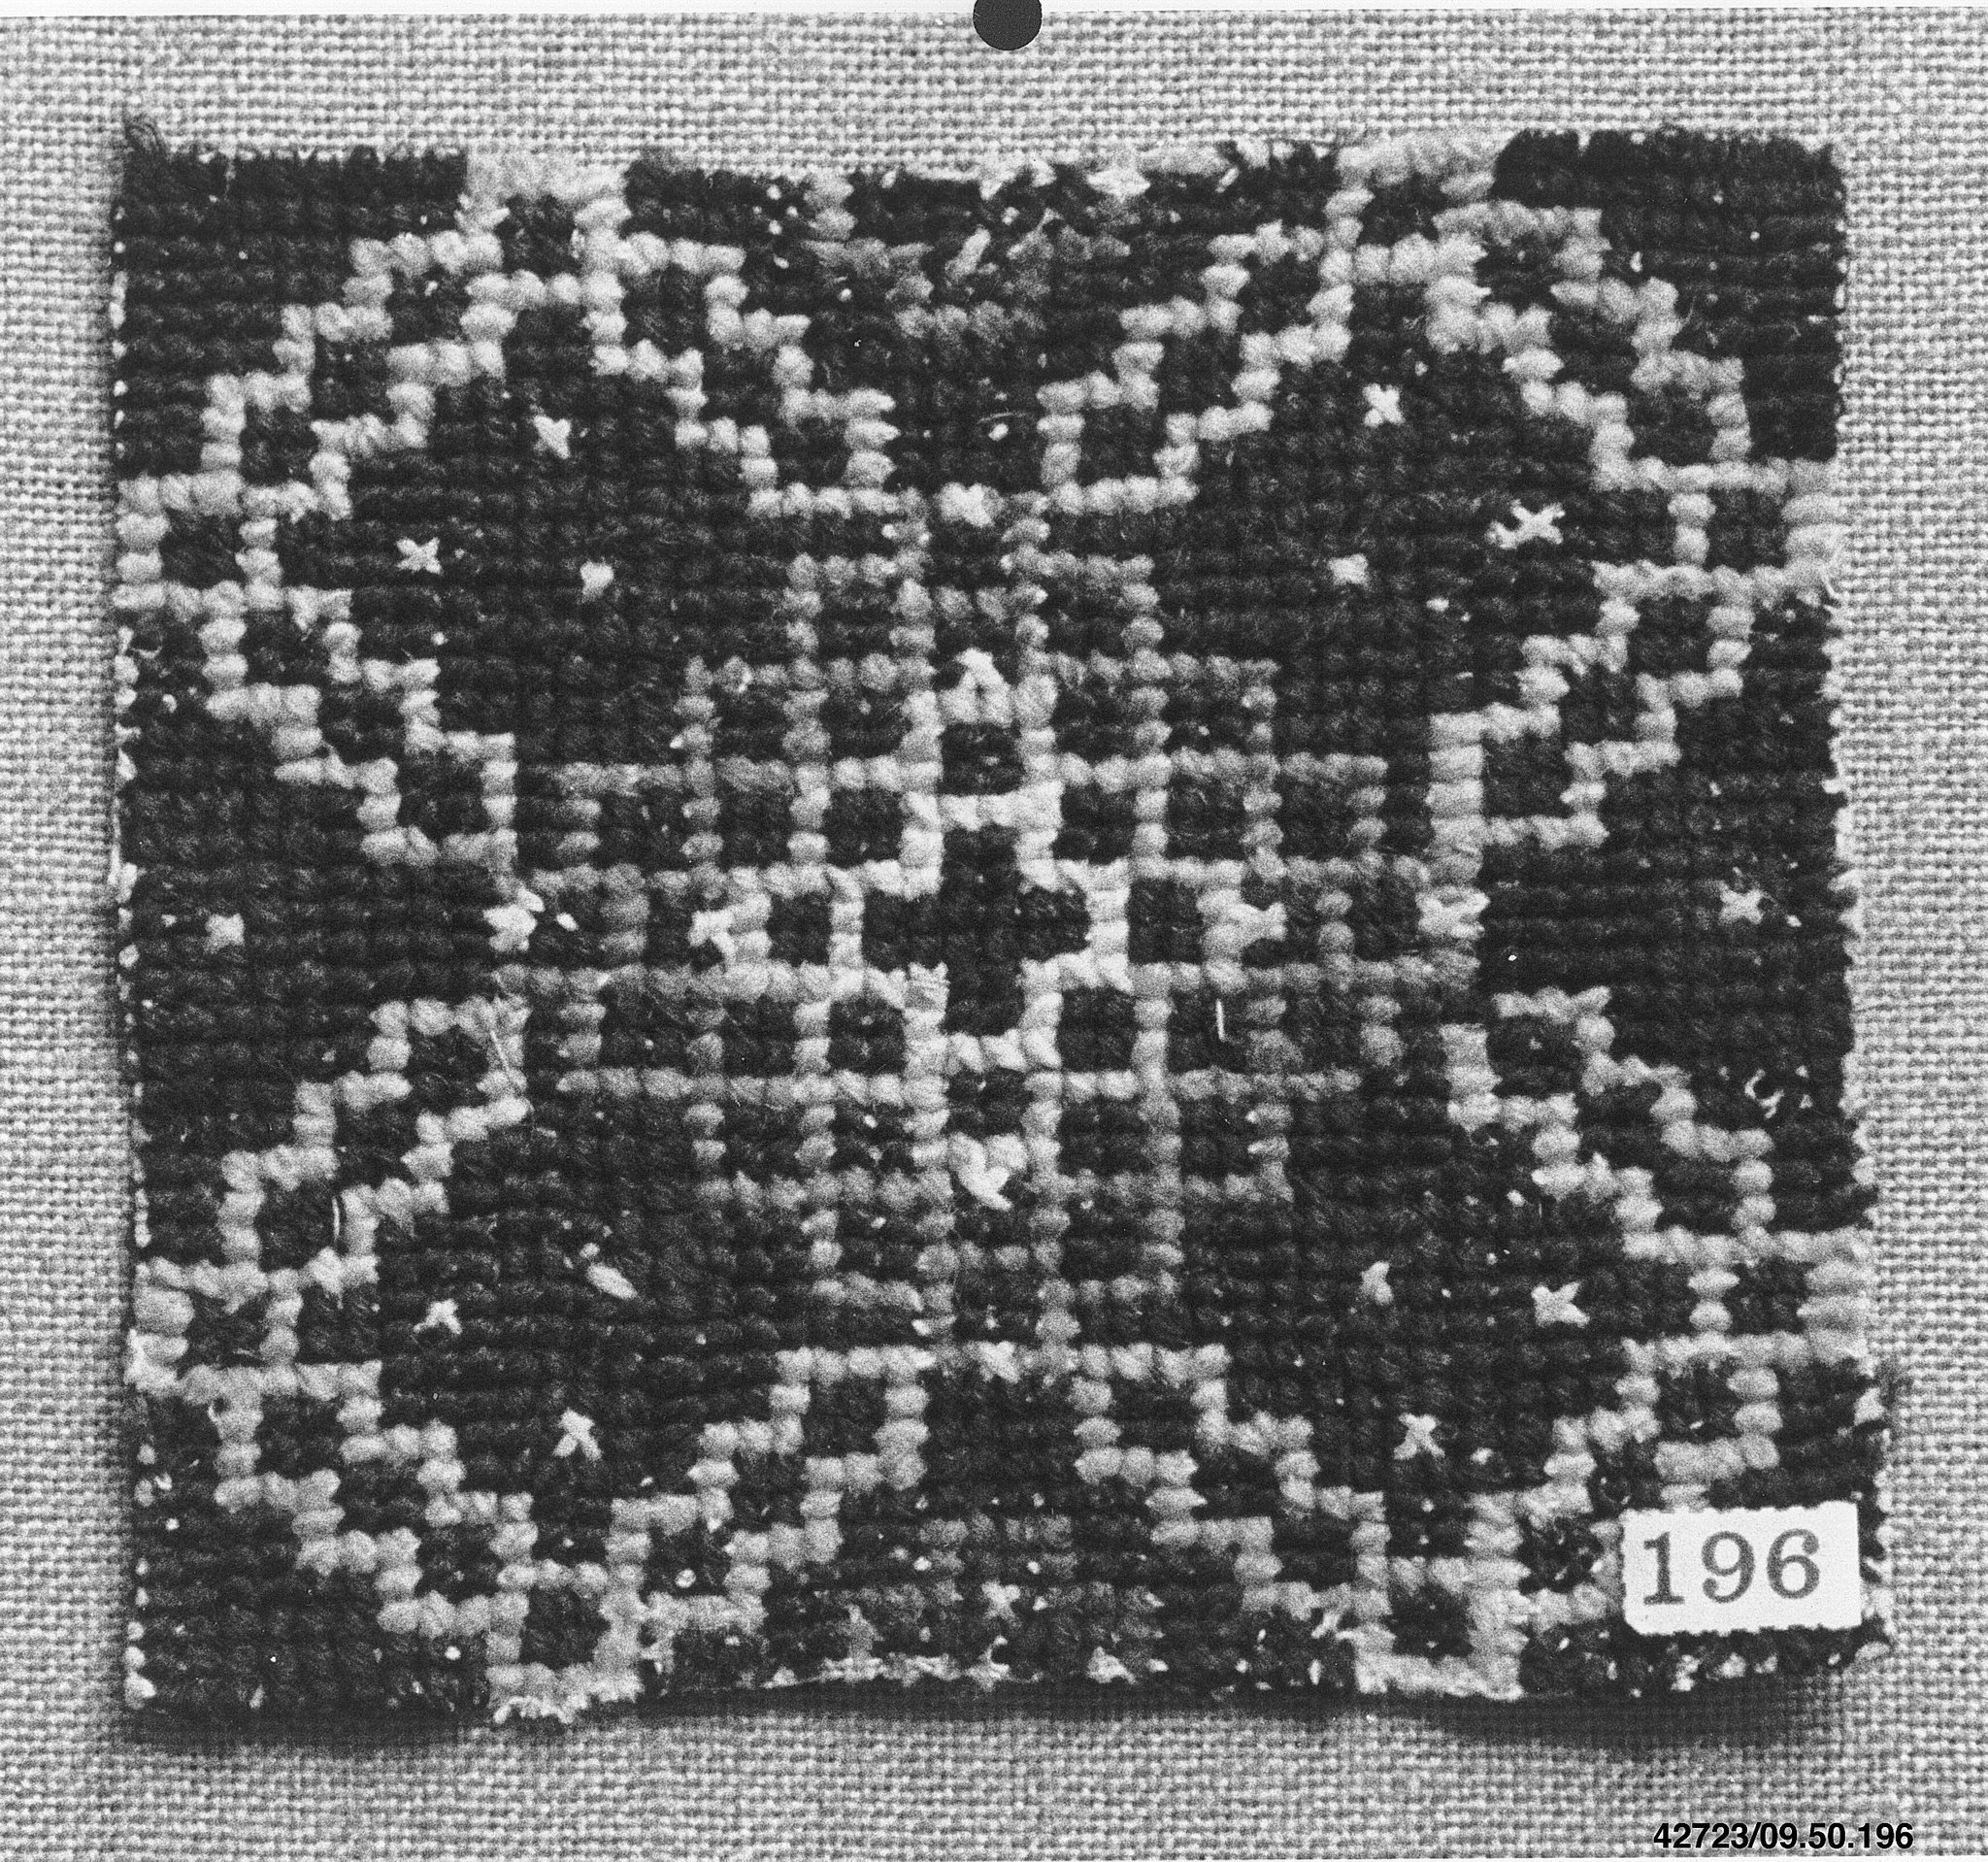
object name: costume fragment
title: Peasant costume fragment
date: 1701-1900